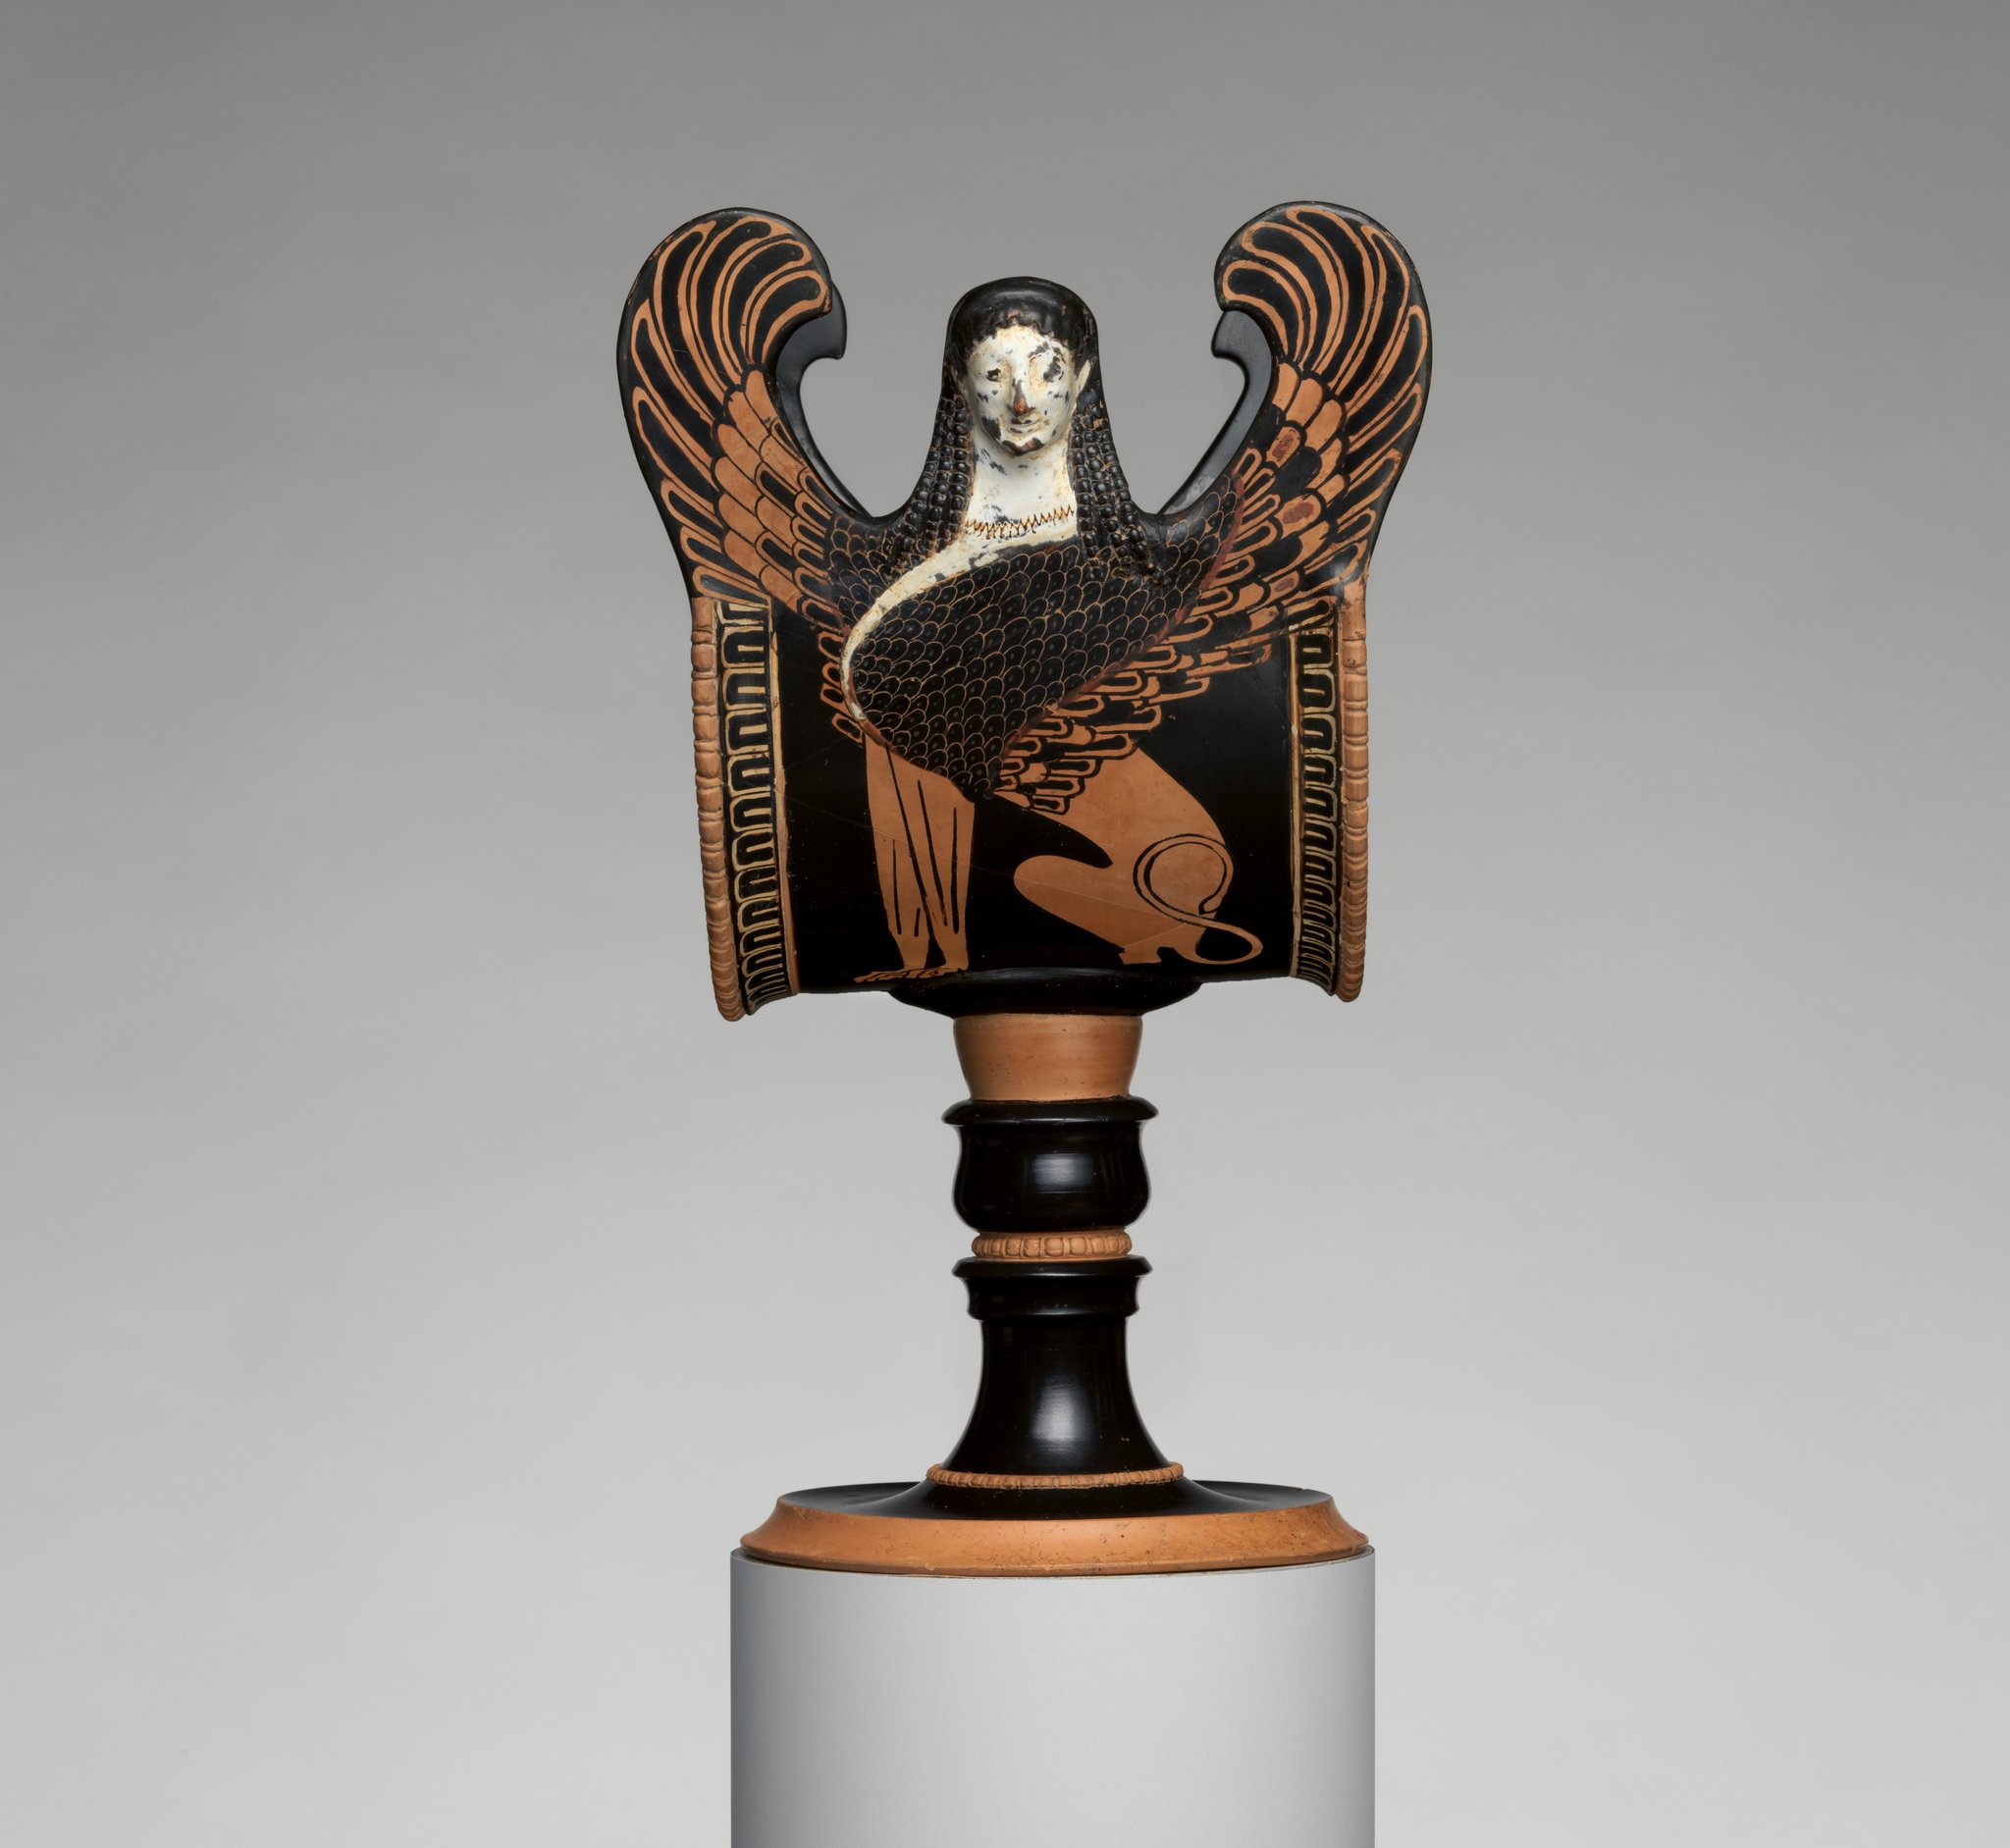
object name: stand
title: Terracotta stand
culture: greek, attic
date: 520 BCE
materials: terracotta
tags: sphinx